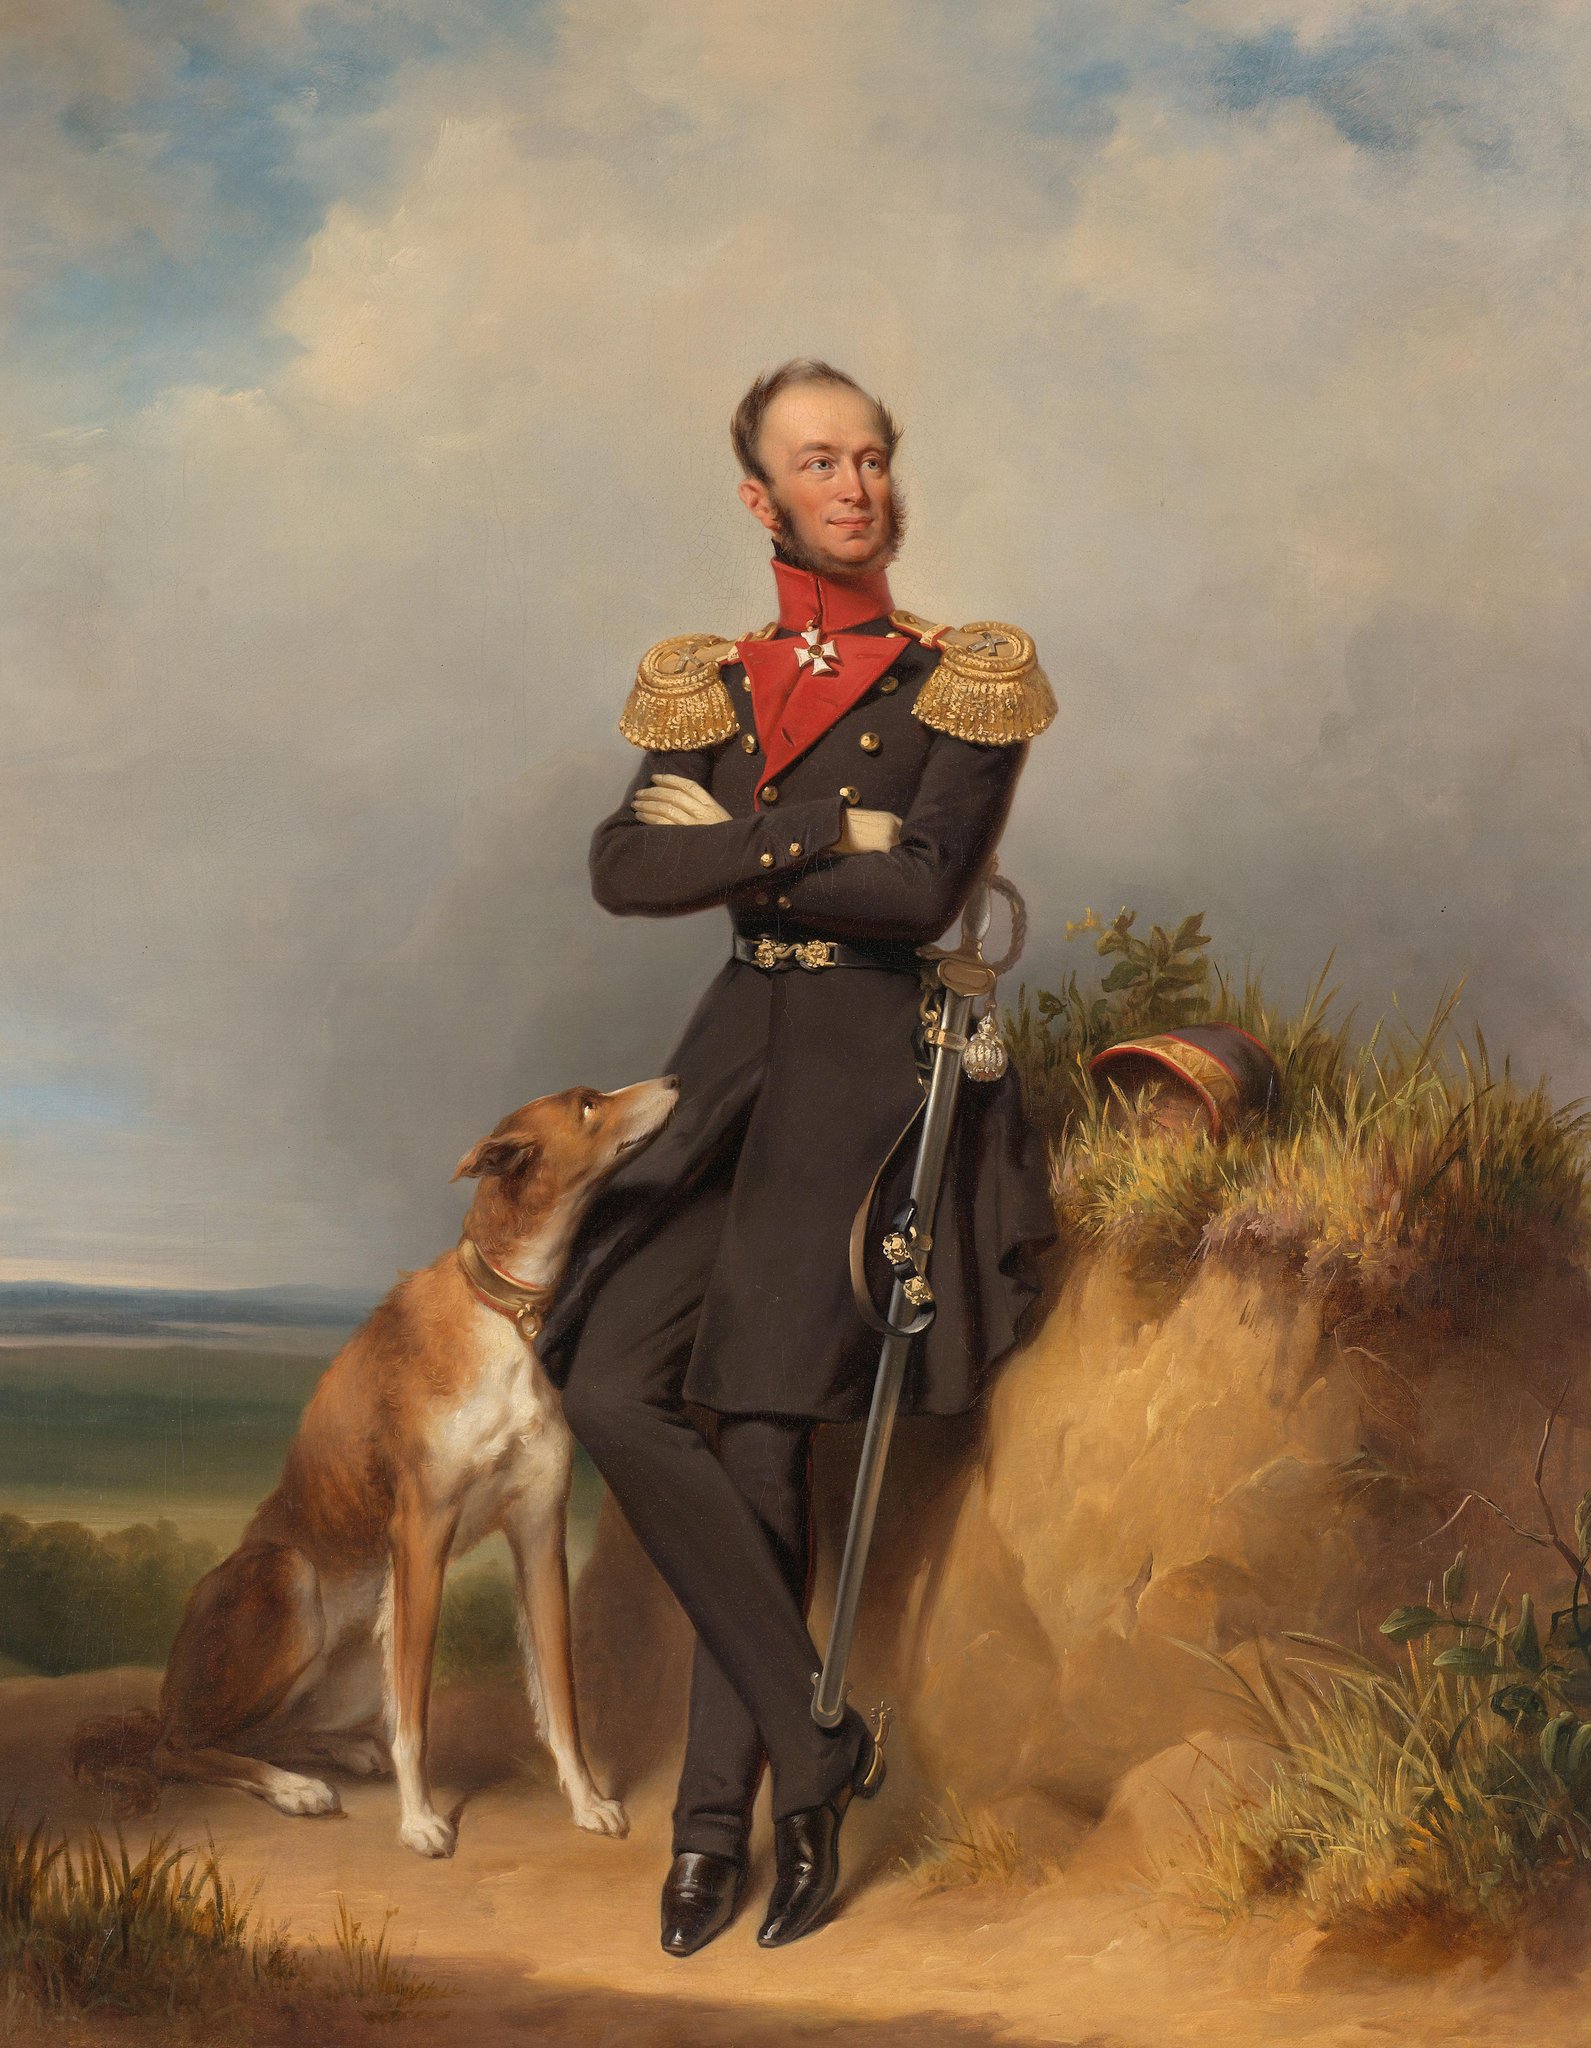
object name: painting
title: Portrait of William II, King of the Netherlands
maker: jan adam kruseman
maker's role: draughtsman, painter, print maker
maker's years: 1804-1862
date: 1839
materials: canvas, oil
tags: the hague, william ii of the netherlands, dune coast, historical persons, dog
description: This is a portrait of King William II in military uniform, but with a decidedly informal air. Accompanied by his hound, he poses casually in the dunes, which in the Romantic era was considered the quintessentially Dutch landscape. In 1848 –when revolutions were raging throughout Europe –William II renounced royal autocracy and the Netherlands became a parliamentary democracy.